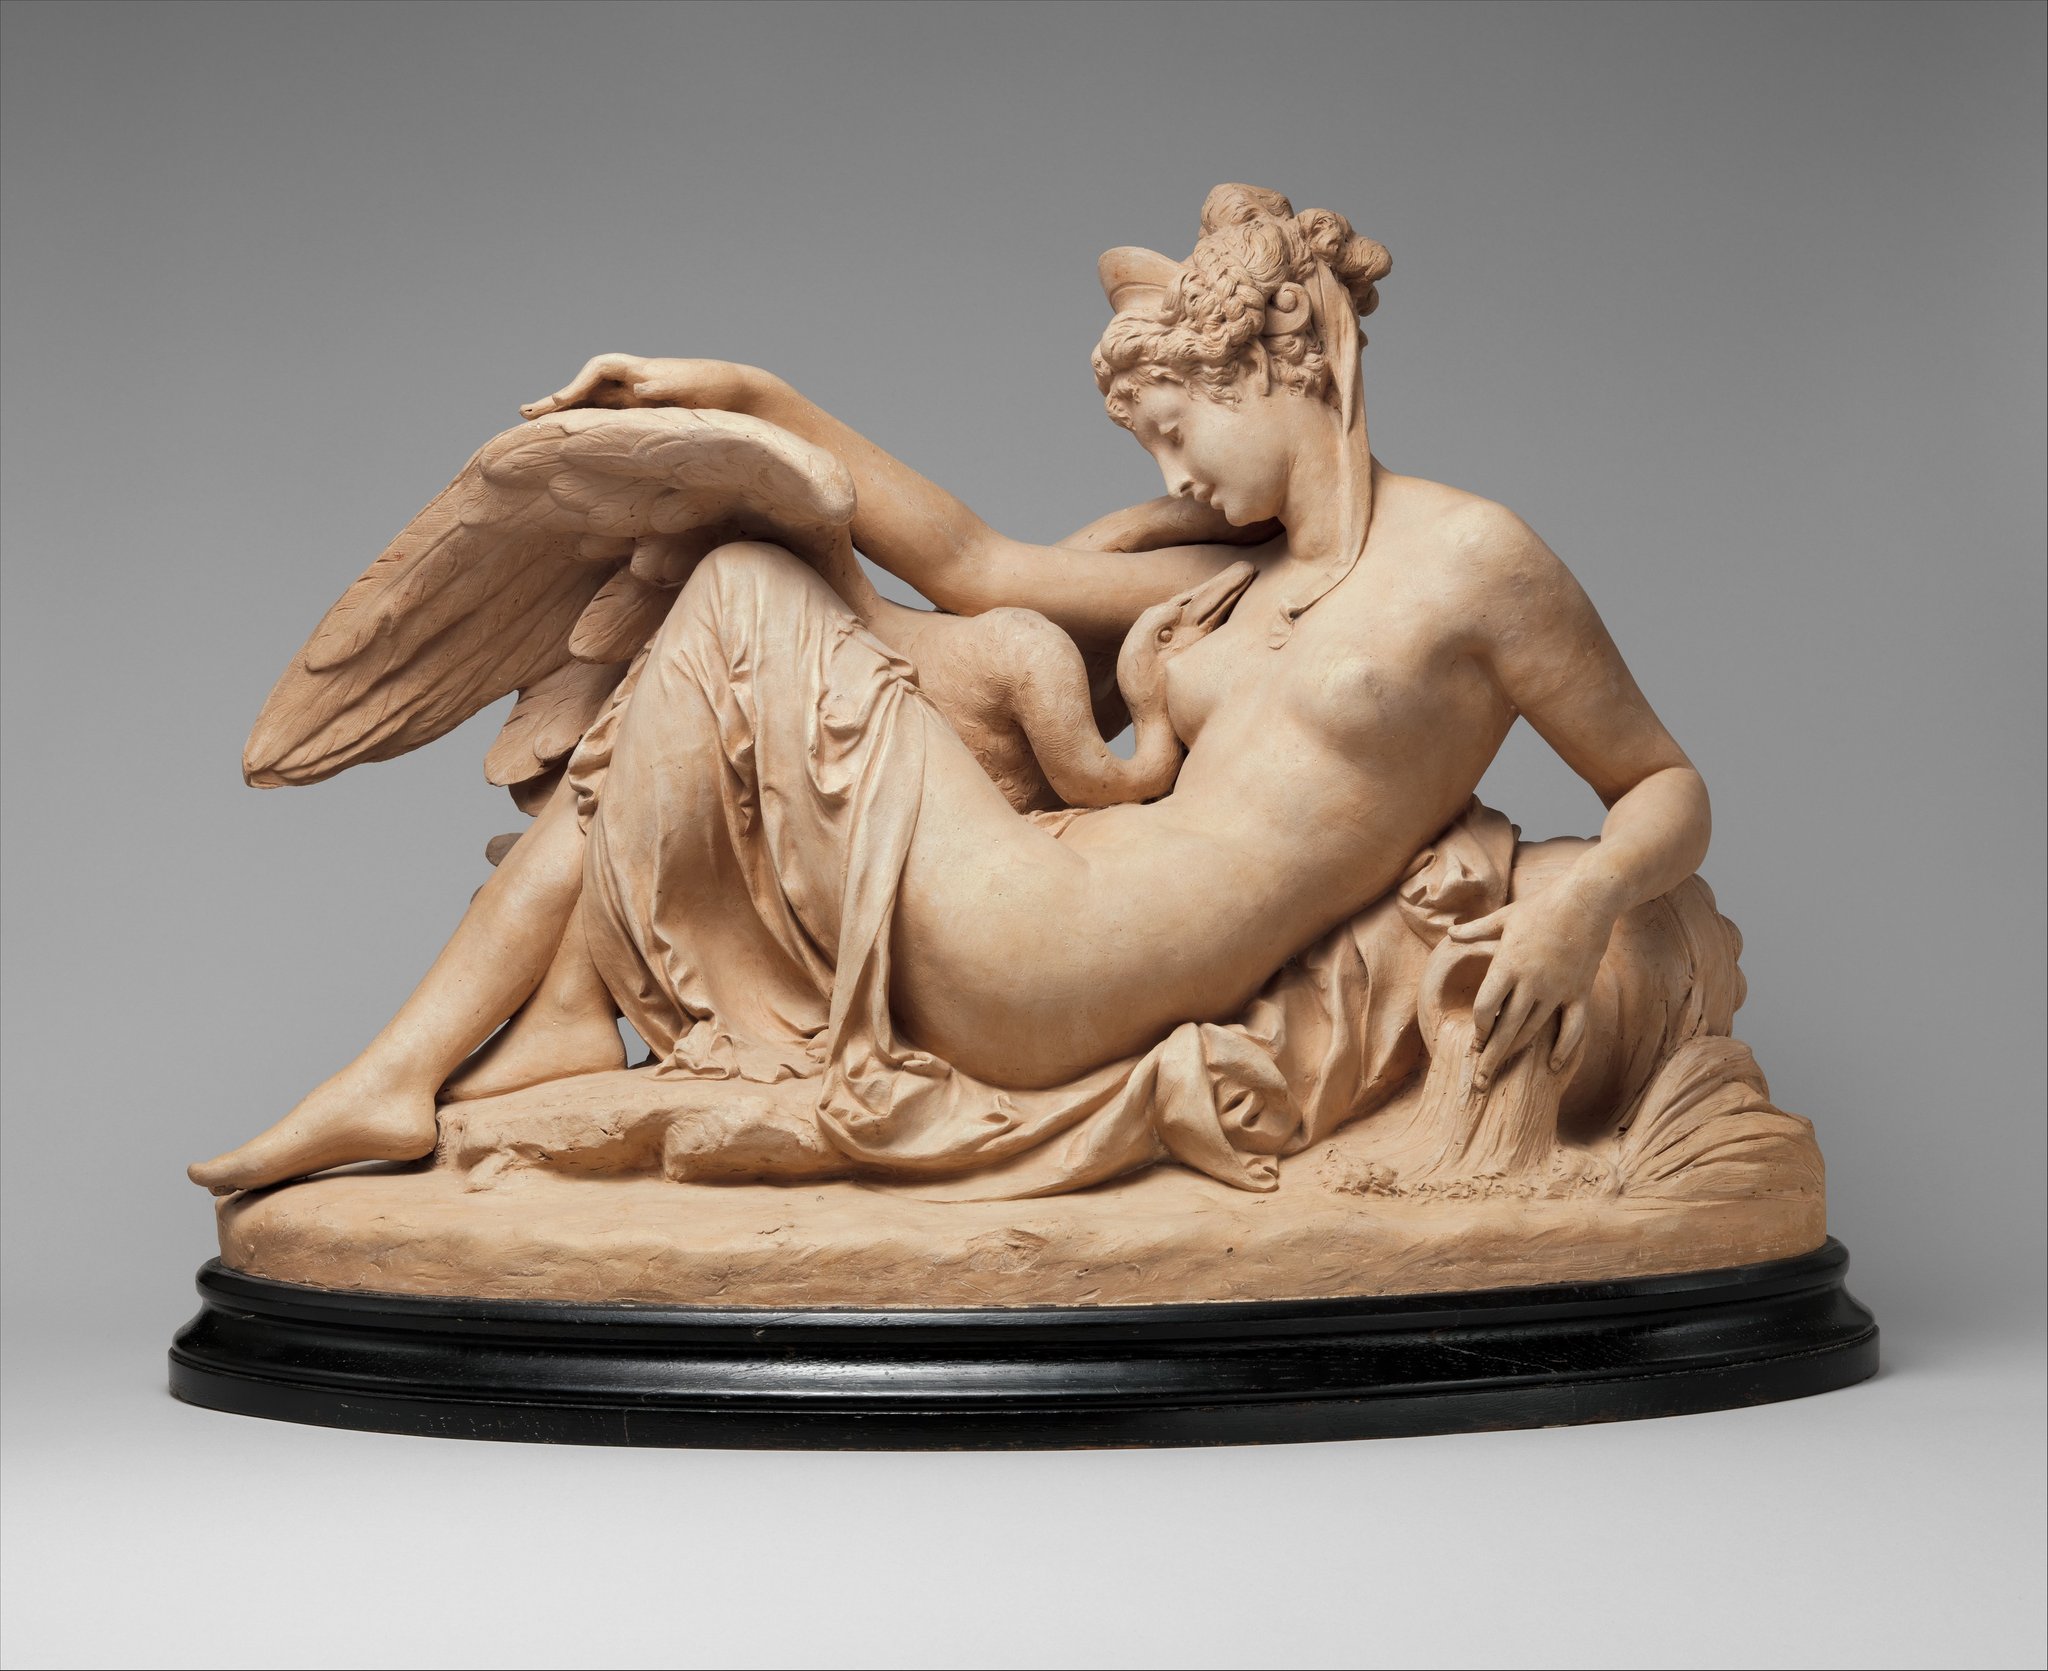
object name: statuette group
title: Leda and the Swan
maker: albert-ernest carrier-belleuse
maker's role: artist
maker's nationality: french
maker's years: 1824-1887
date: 1870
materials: terracotta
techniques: casting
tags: leda,swans